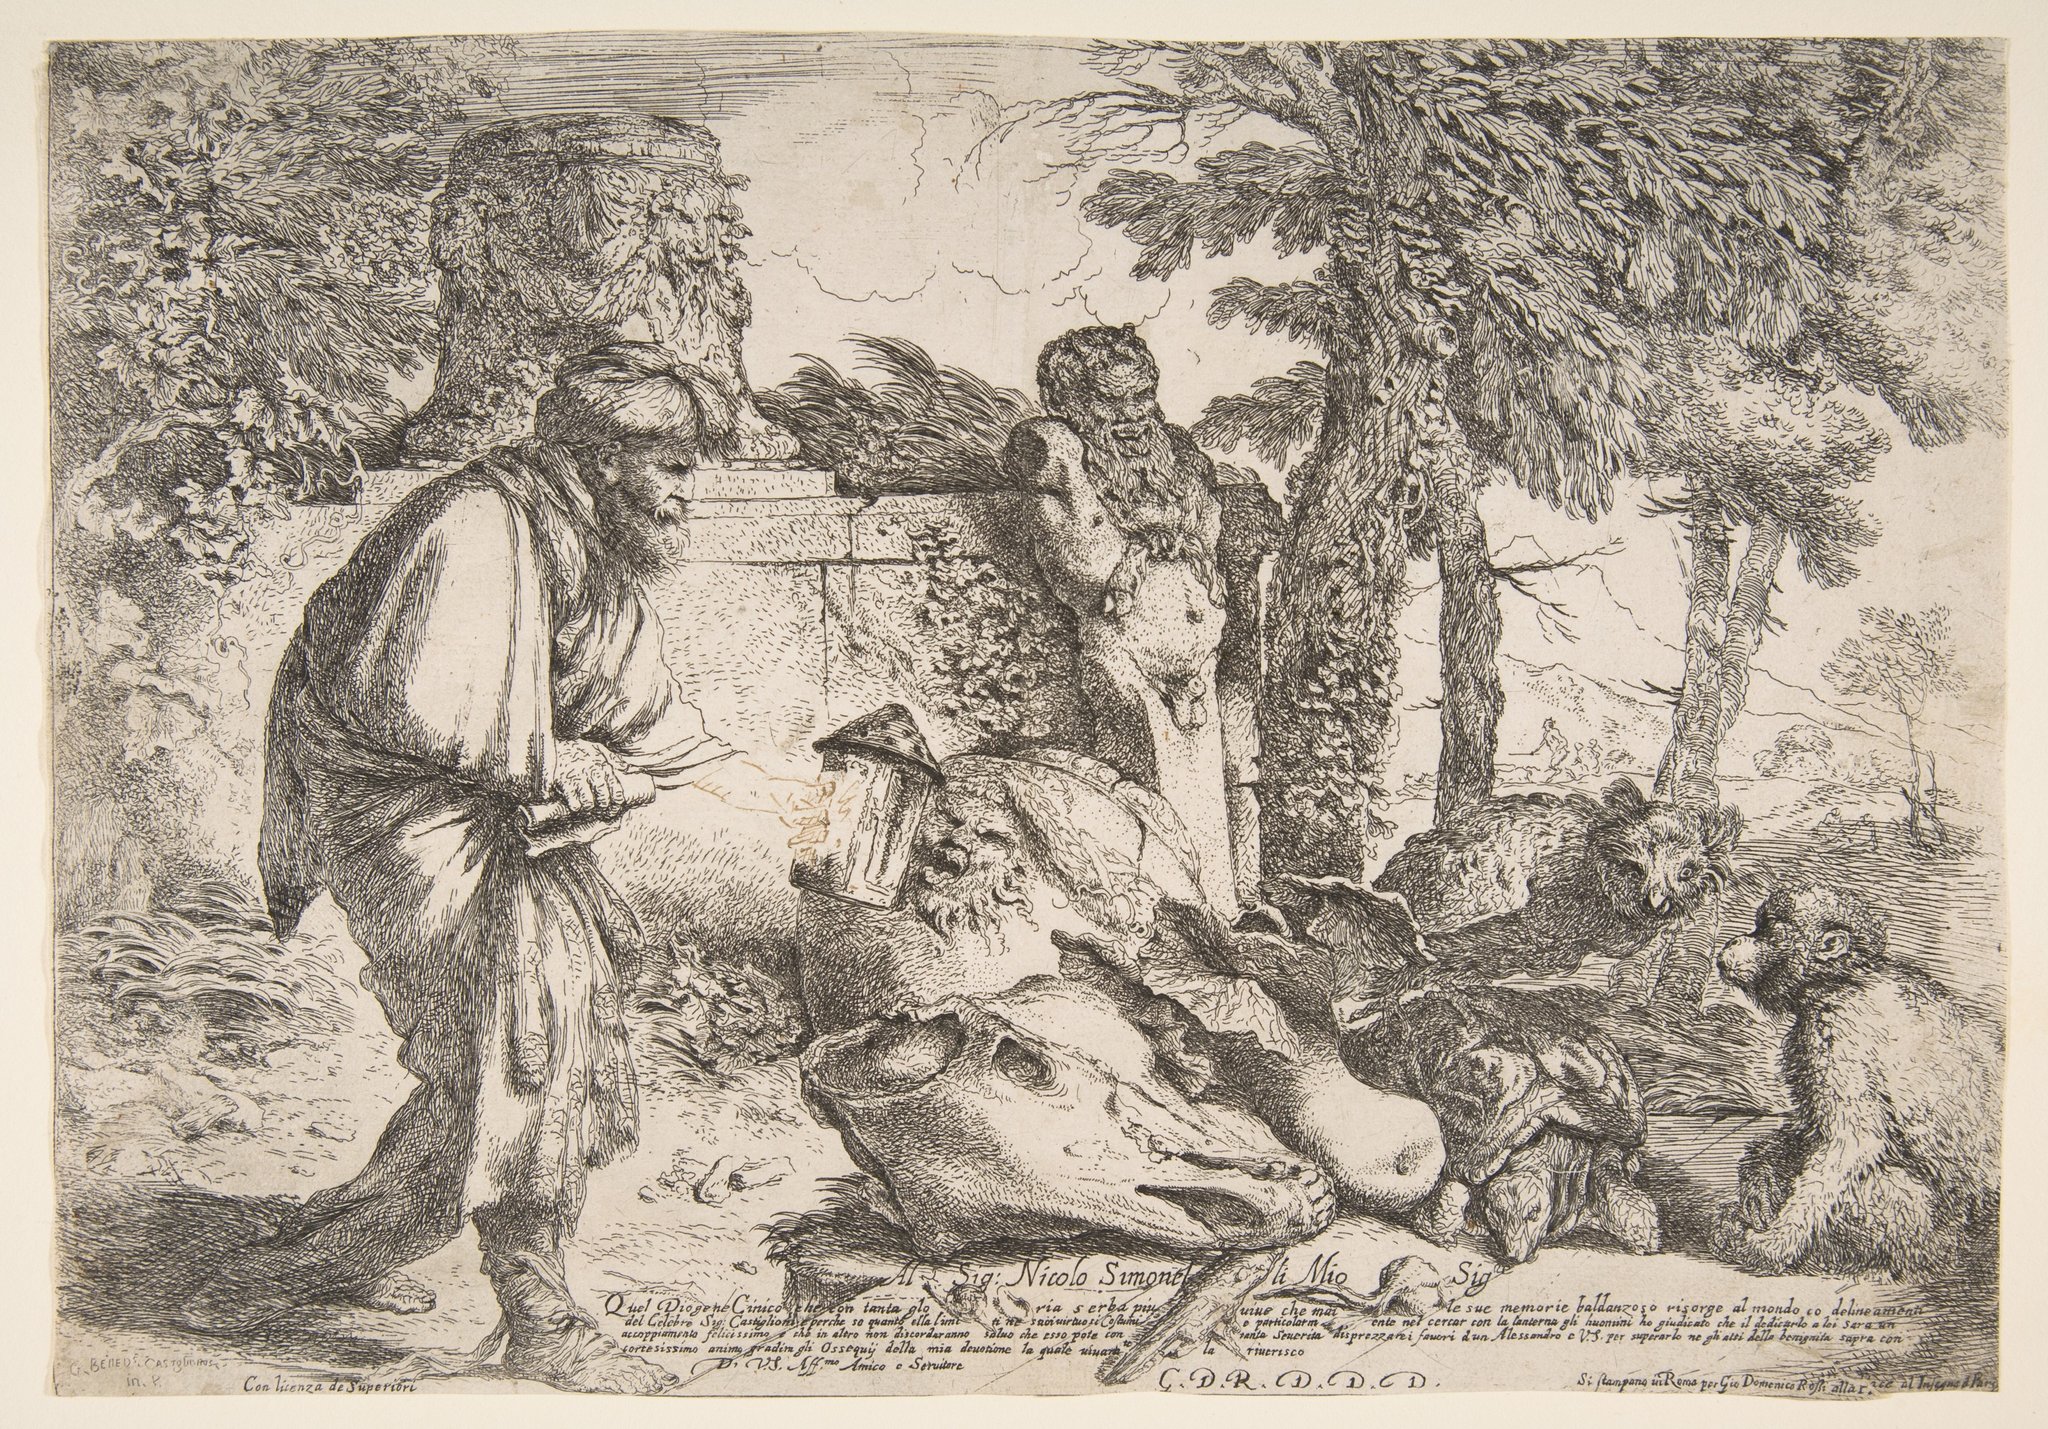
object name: print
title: Diogenes searching for a honest man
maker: giovanni benedetto castiglione (il grechetto)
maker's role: artist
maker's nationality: italian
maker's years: 1609-1664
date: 1645-1647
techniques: etching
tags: diogenes,male nudes,monkeys